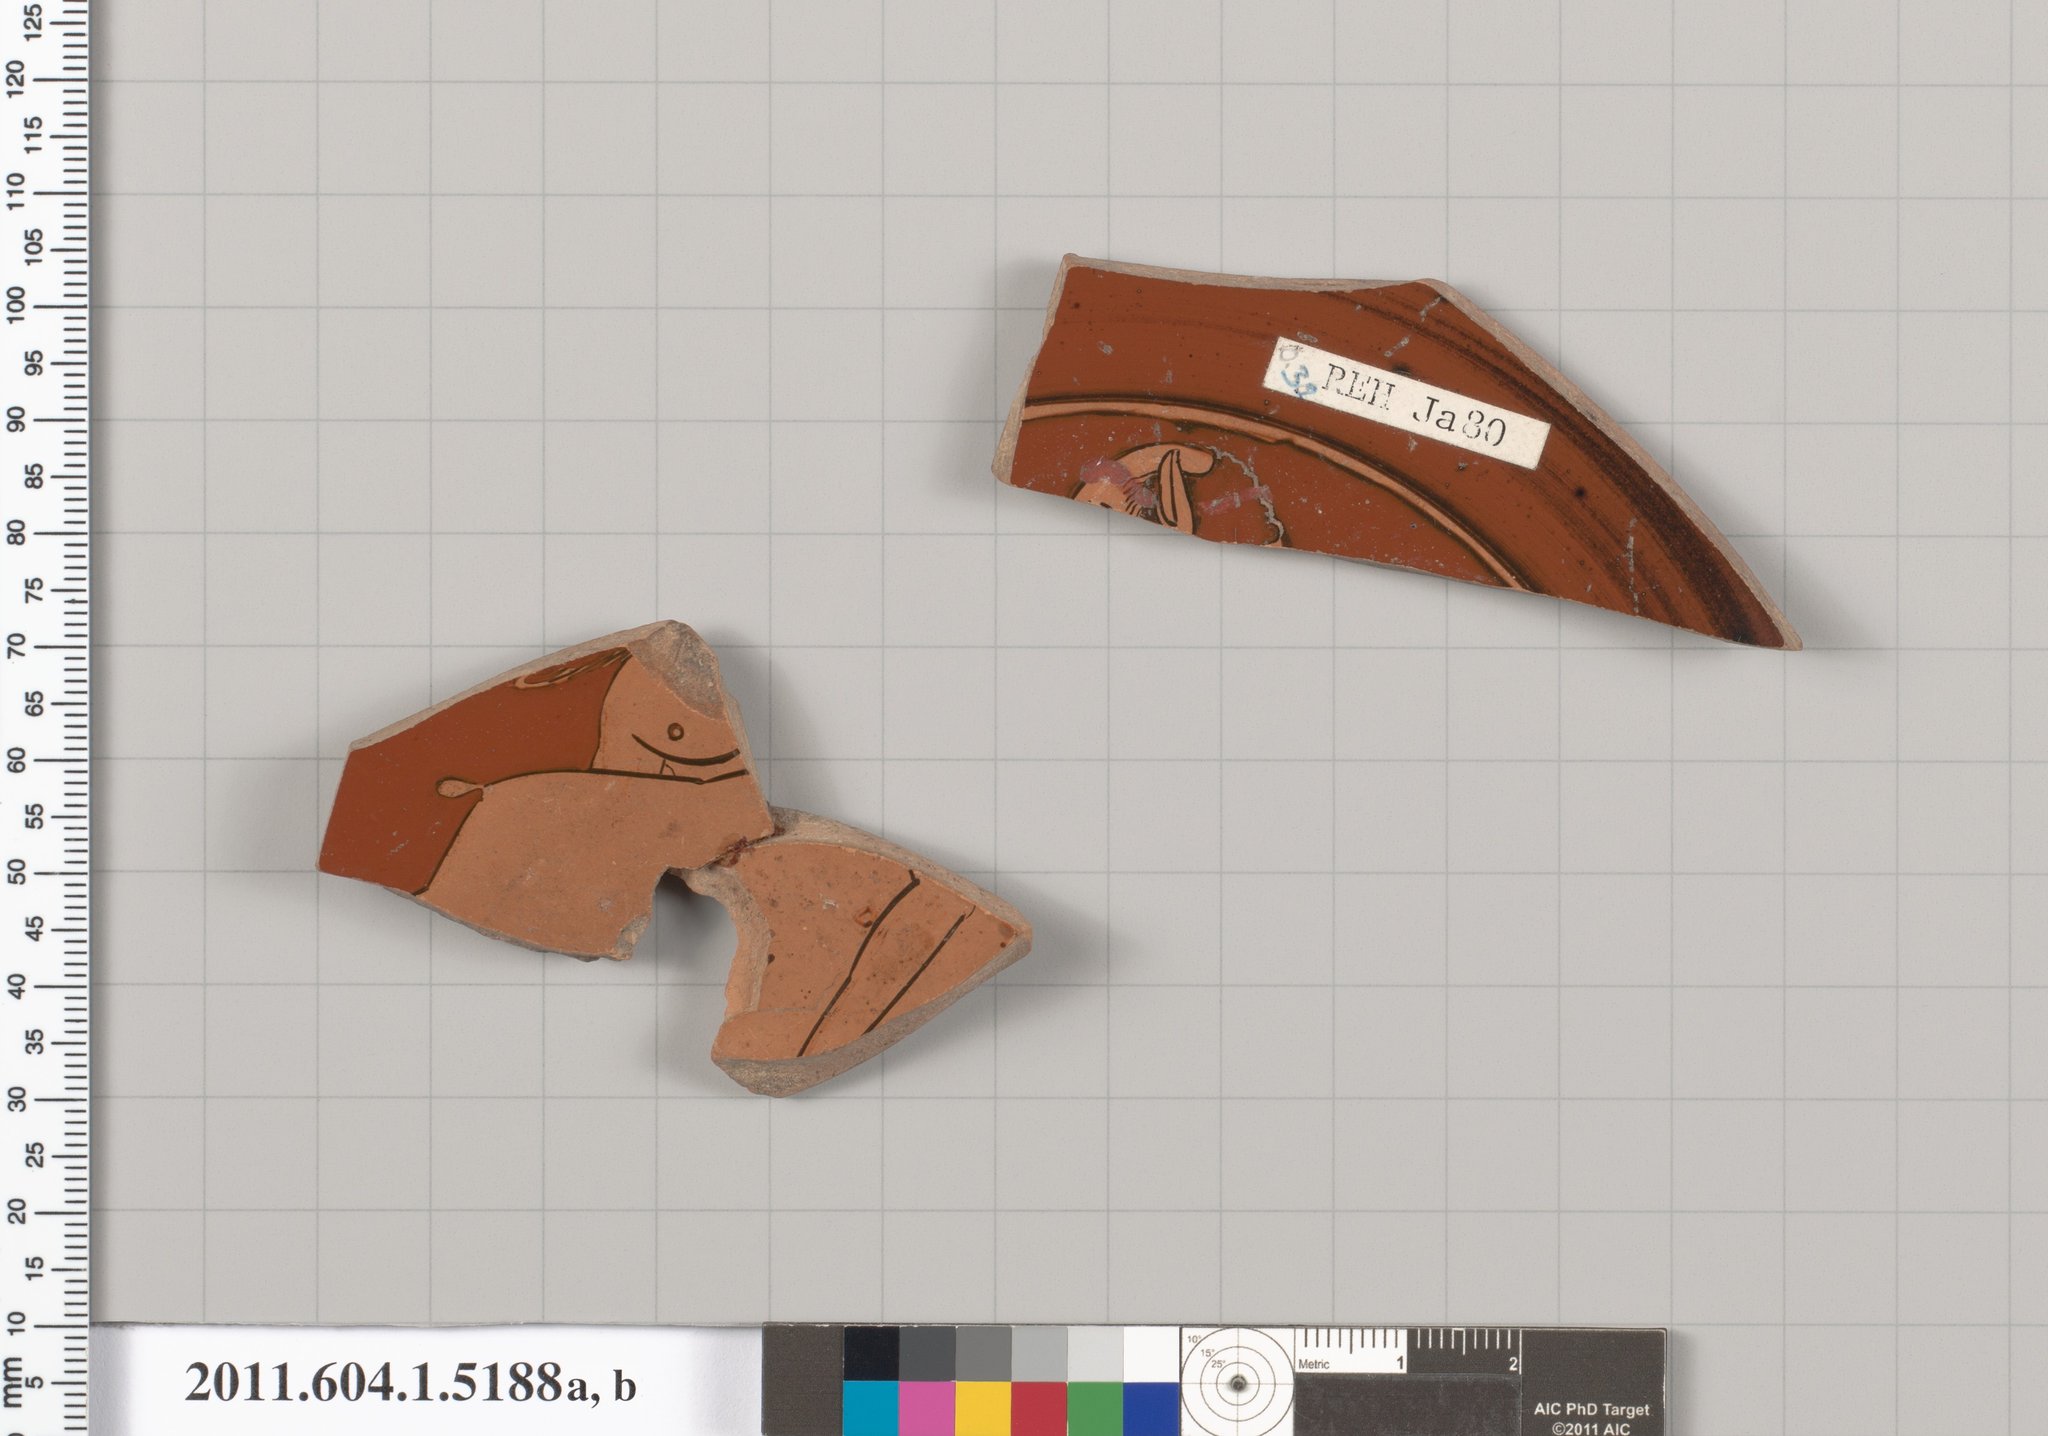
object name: kylix fragment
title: Terracotta fragments of a kylix (drinking cups)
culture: greek, attic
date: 510-490 BCE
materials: terracotta